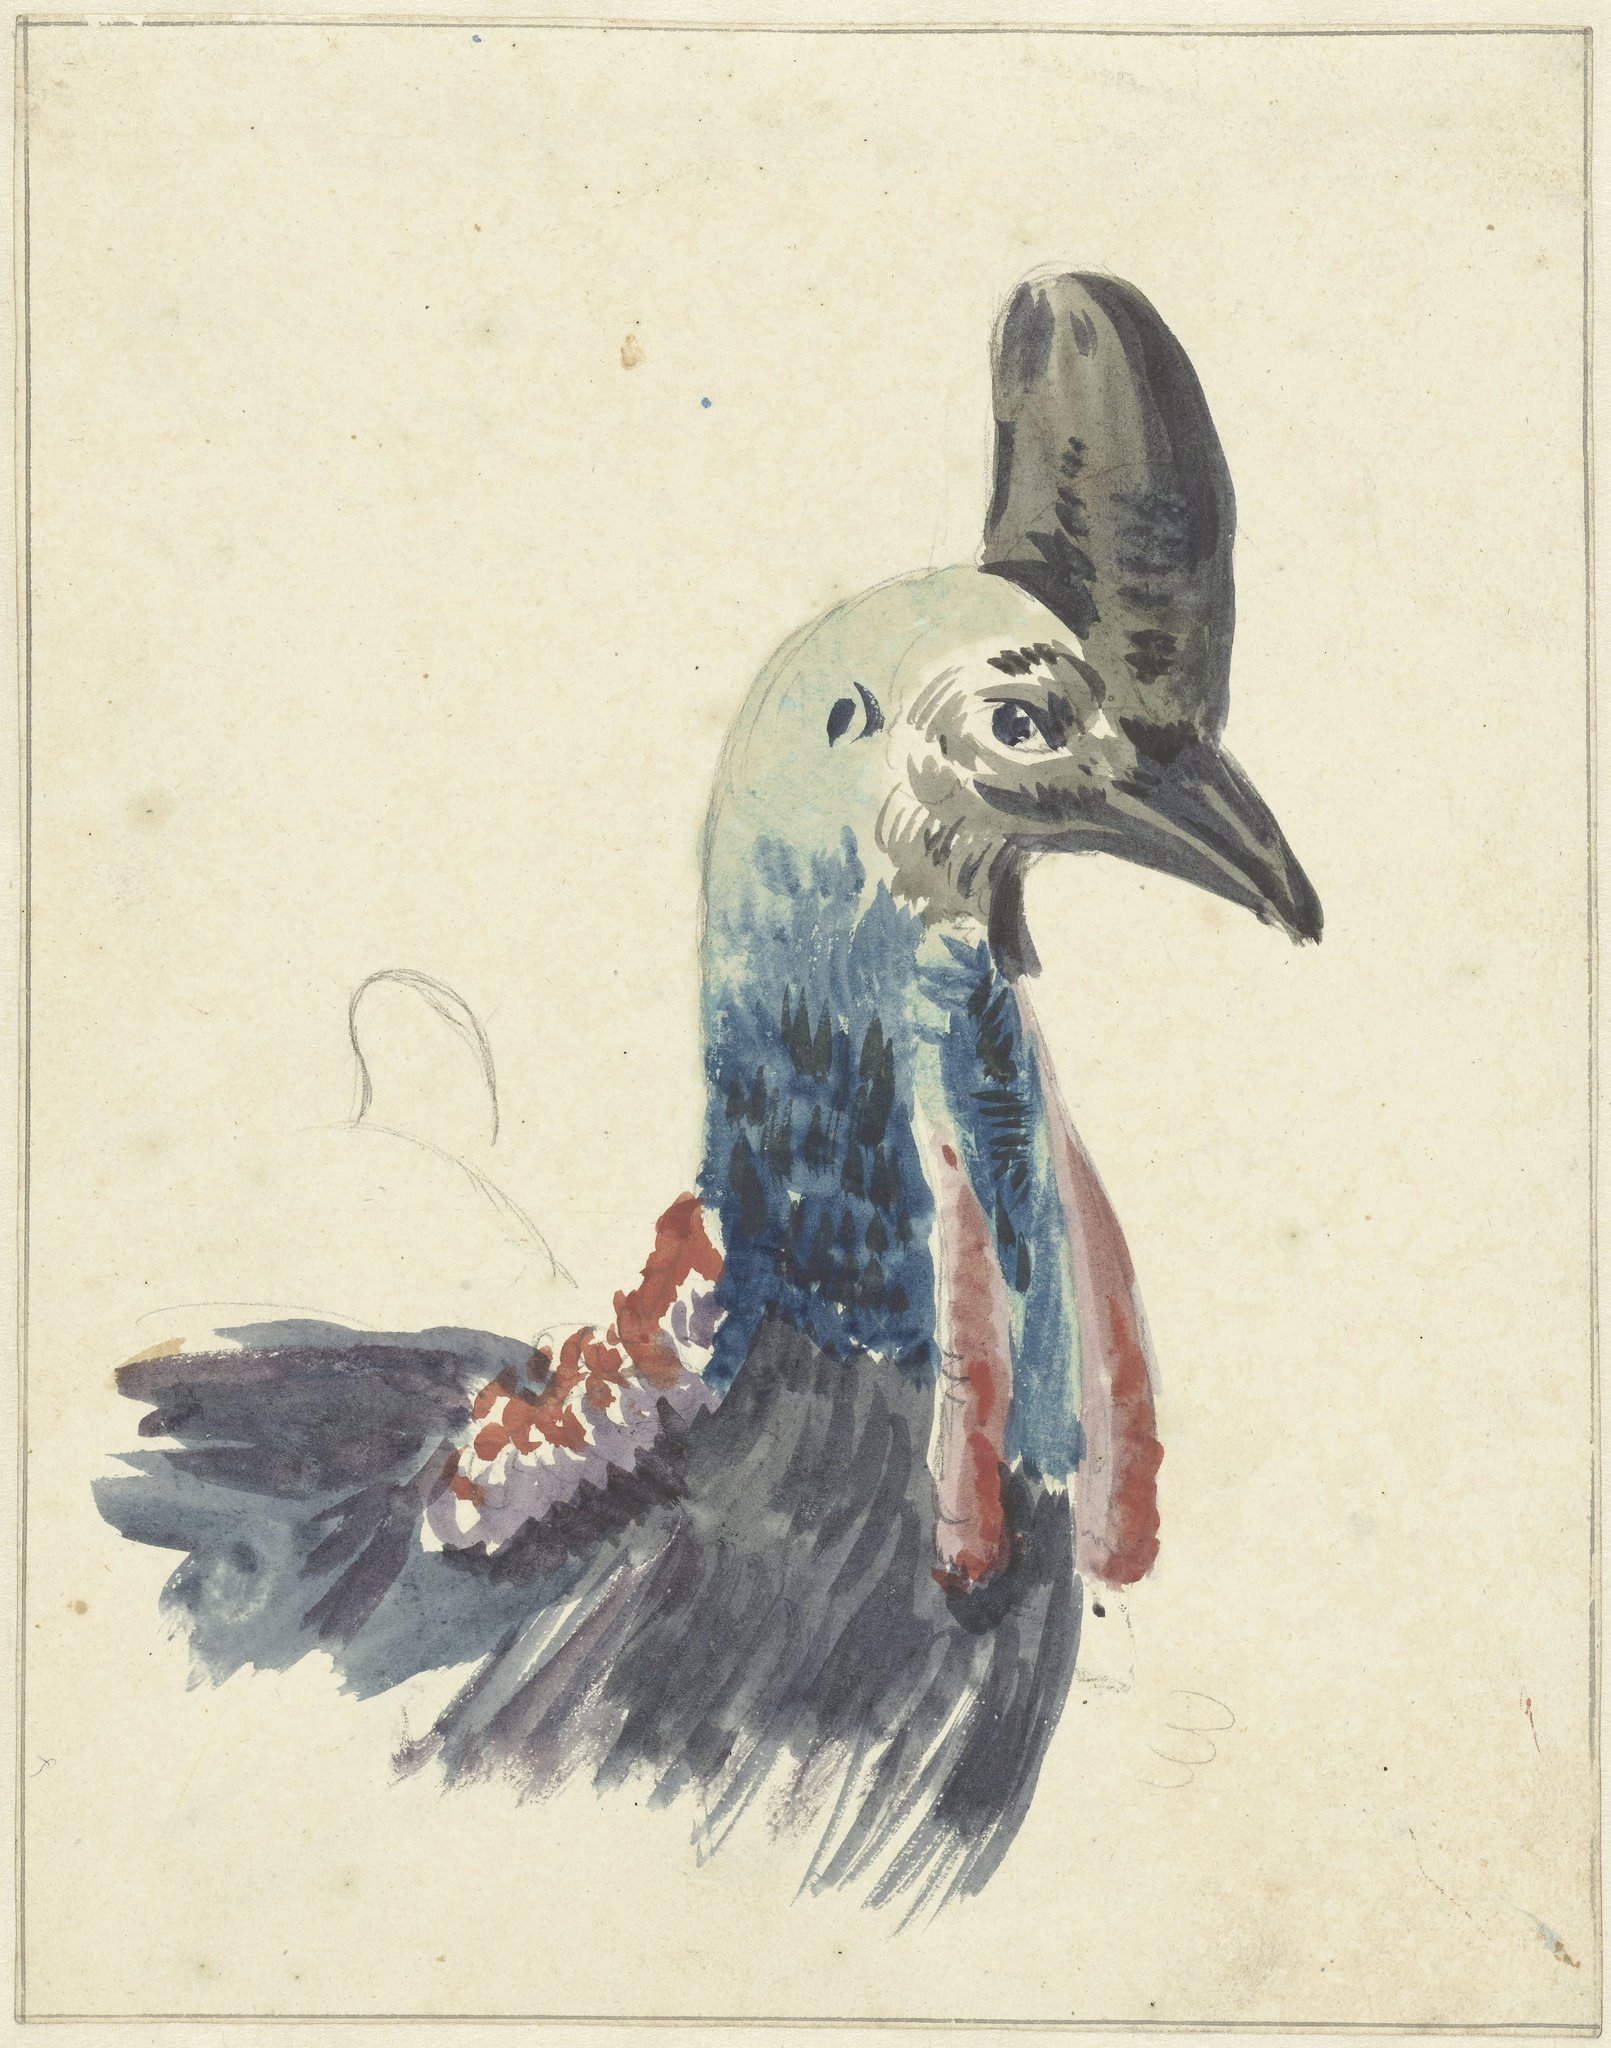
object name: drawing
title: Kop van de Kasuaris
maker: christiaan van geelen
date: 1700-1800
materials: paper, pencil, watercolor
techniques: brush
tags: walker and runner birds: cassowary